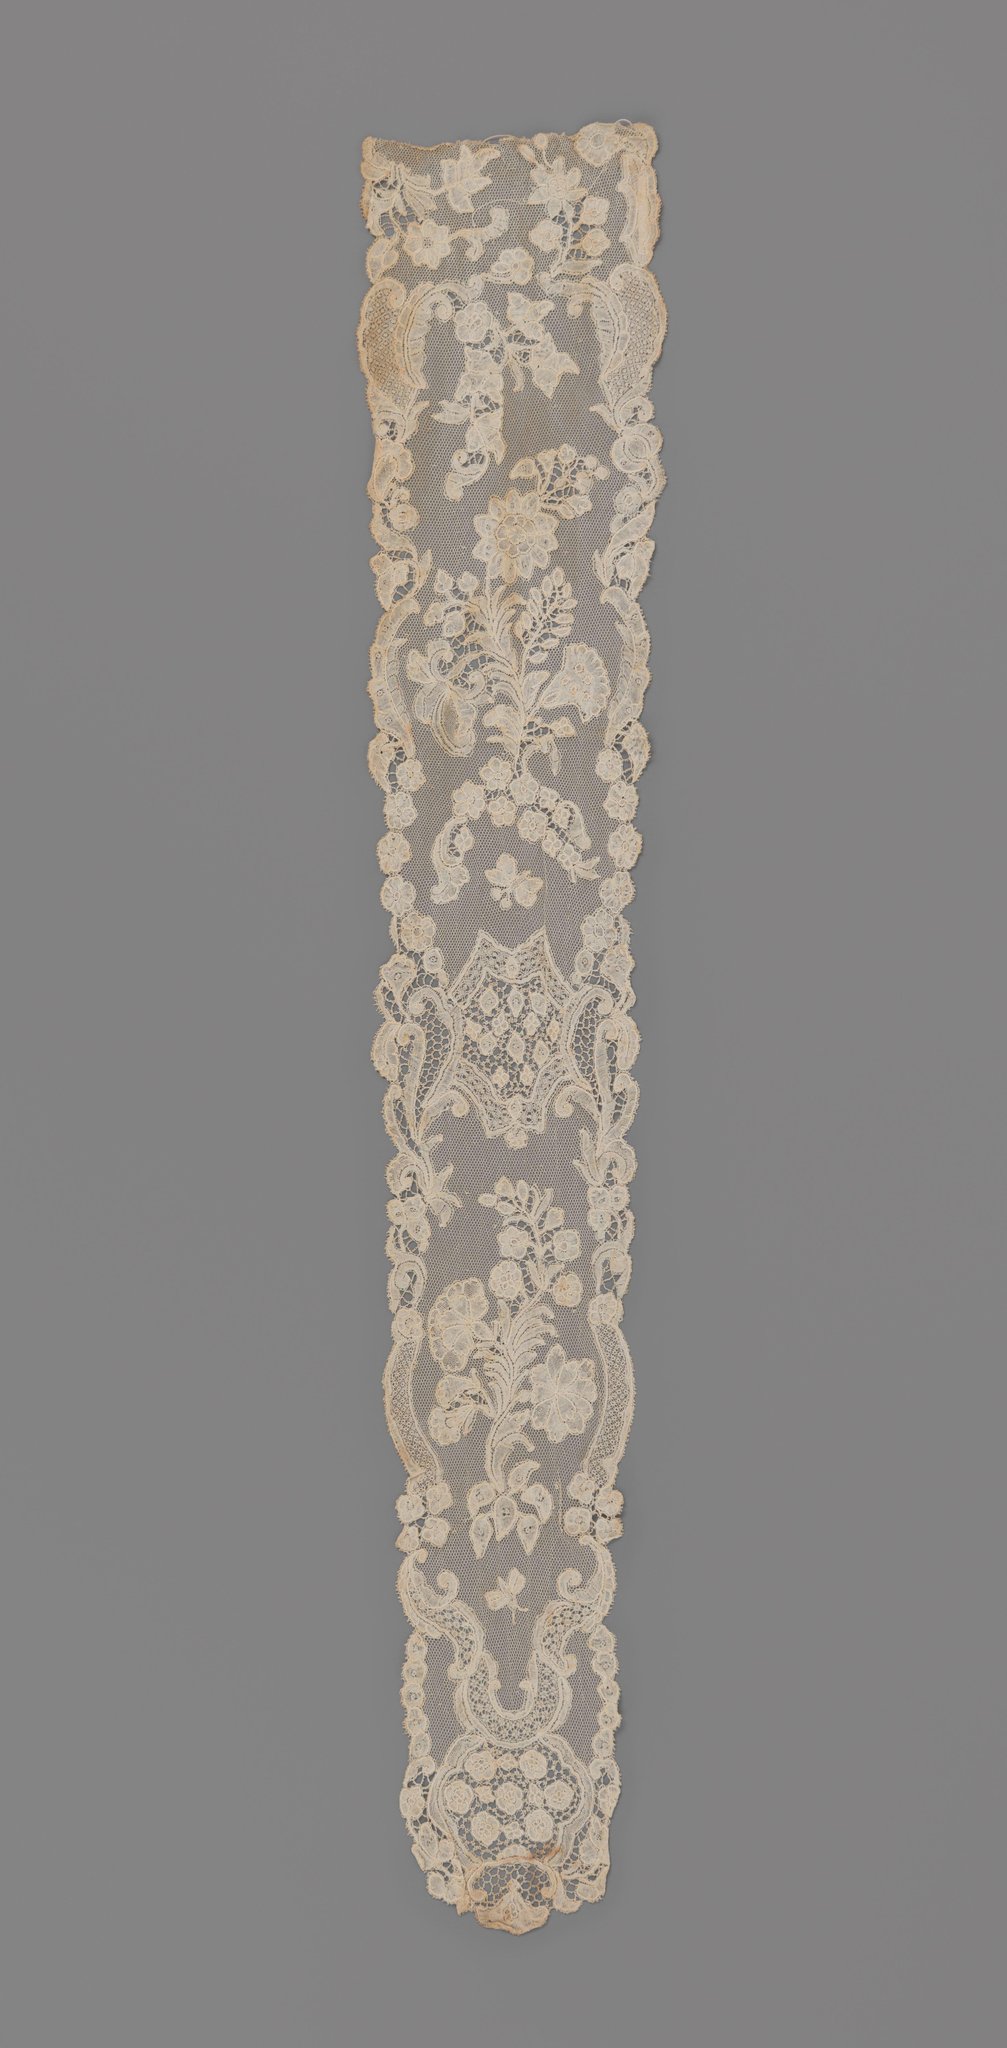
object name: womenswear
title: Mutsenslip (barbe) van Brusselse kloskant gedecoreerd met onder meer een vlieg en een vlinder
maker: Anonymous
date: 1735-1750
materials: linen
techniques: lace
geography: brussels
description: Mutsenslip van kloskant. Het patroon heeft onderaan een gelobd ovaal met bloemen op een rasterwerk, vlinders en een lange, samengestelde bloemtak. In het midden heeft het patroon een hol geschulpt medaillon met ruiten en klavertjes-vier op een raster, een vlinder en een gevarieerde bloemtak. Bij de mutsenslip hoort een mutsenslip met het invnr. BK-1978-607-B en vier stroken (BK-1978-607-C t/m BK-1978-607-F).